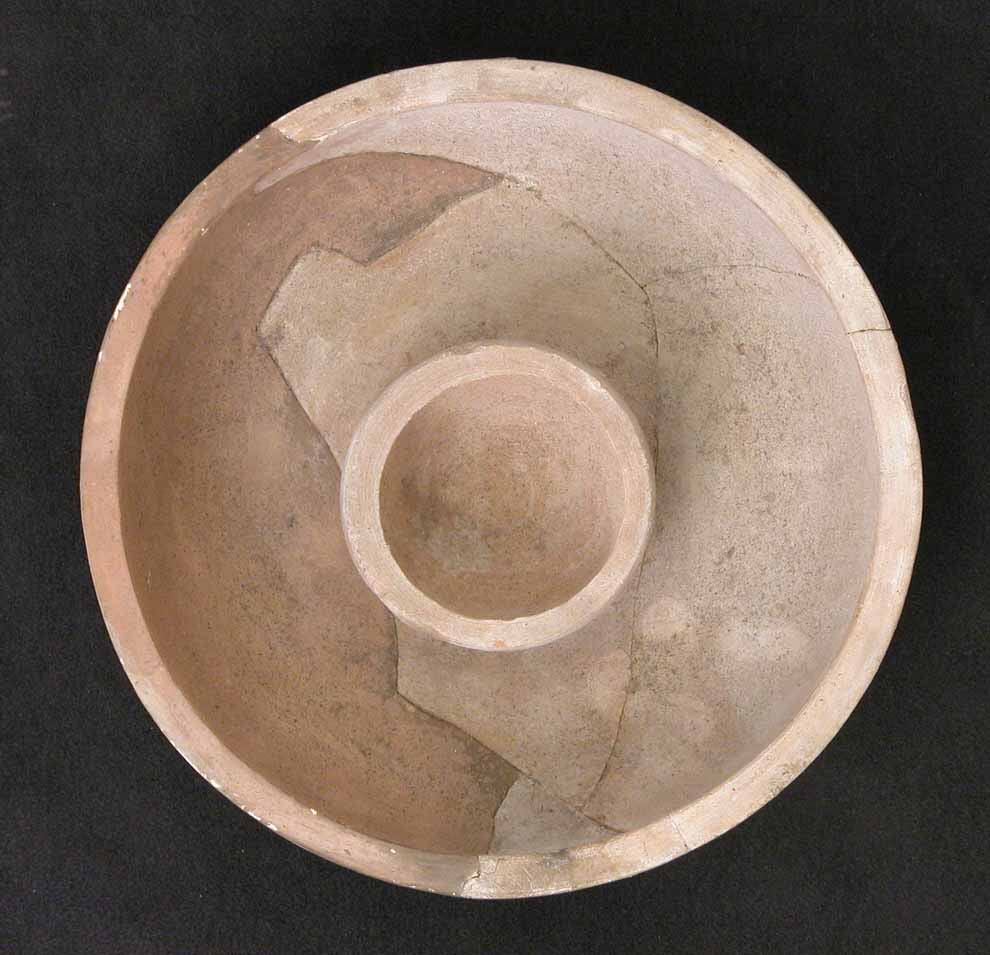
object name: bowl or lamp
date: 801-933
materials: earthenware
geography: iran